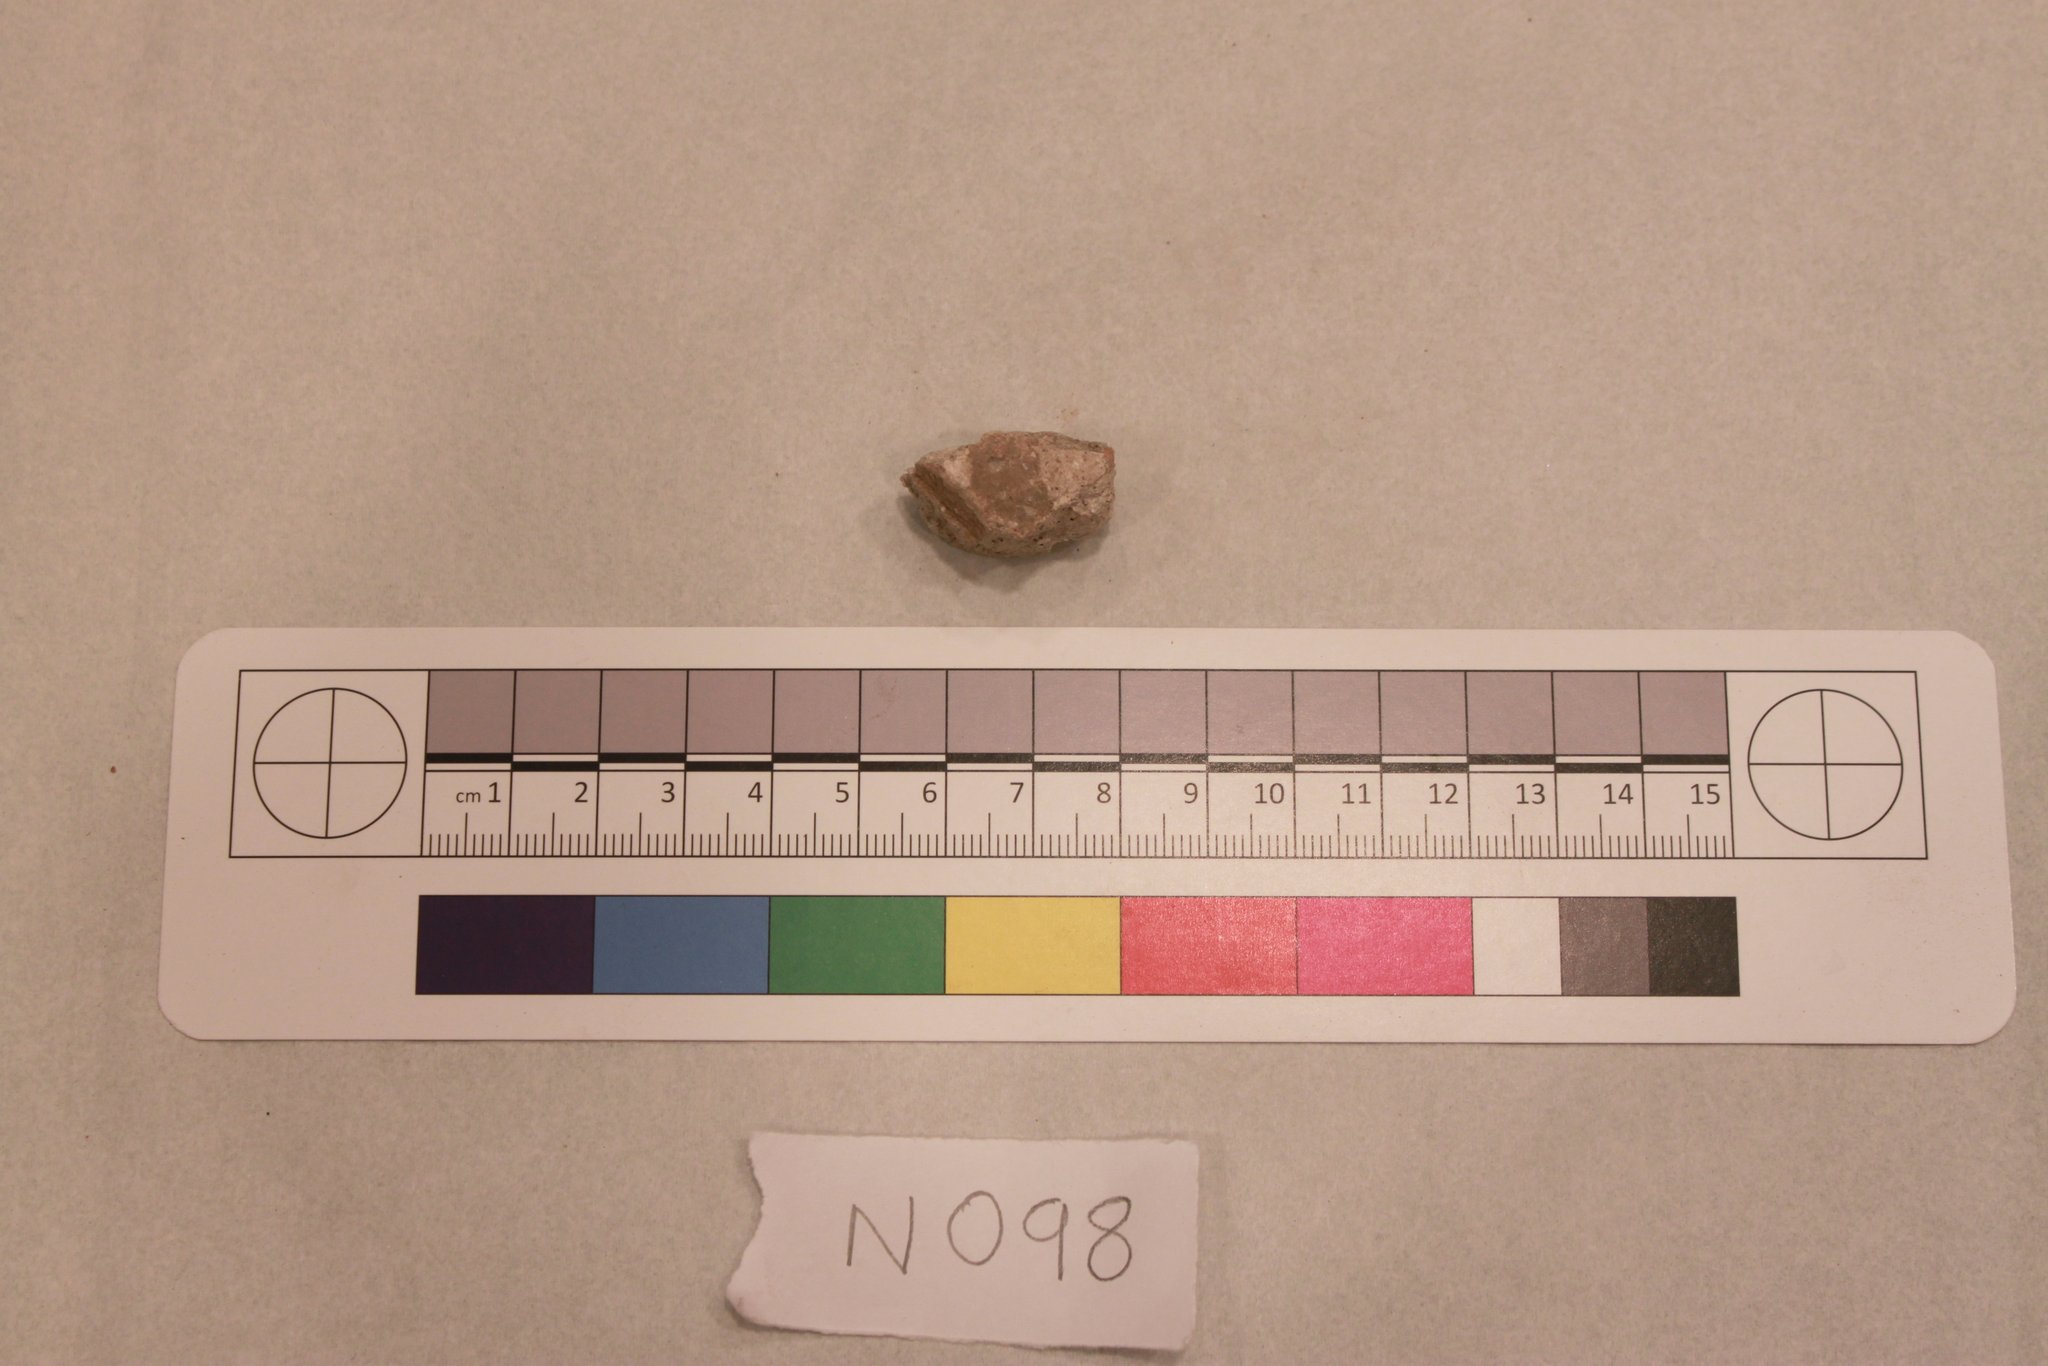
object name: fragment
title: Stucco Fragment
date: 701-1200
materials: plaster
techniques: carving, painting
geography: iran